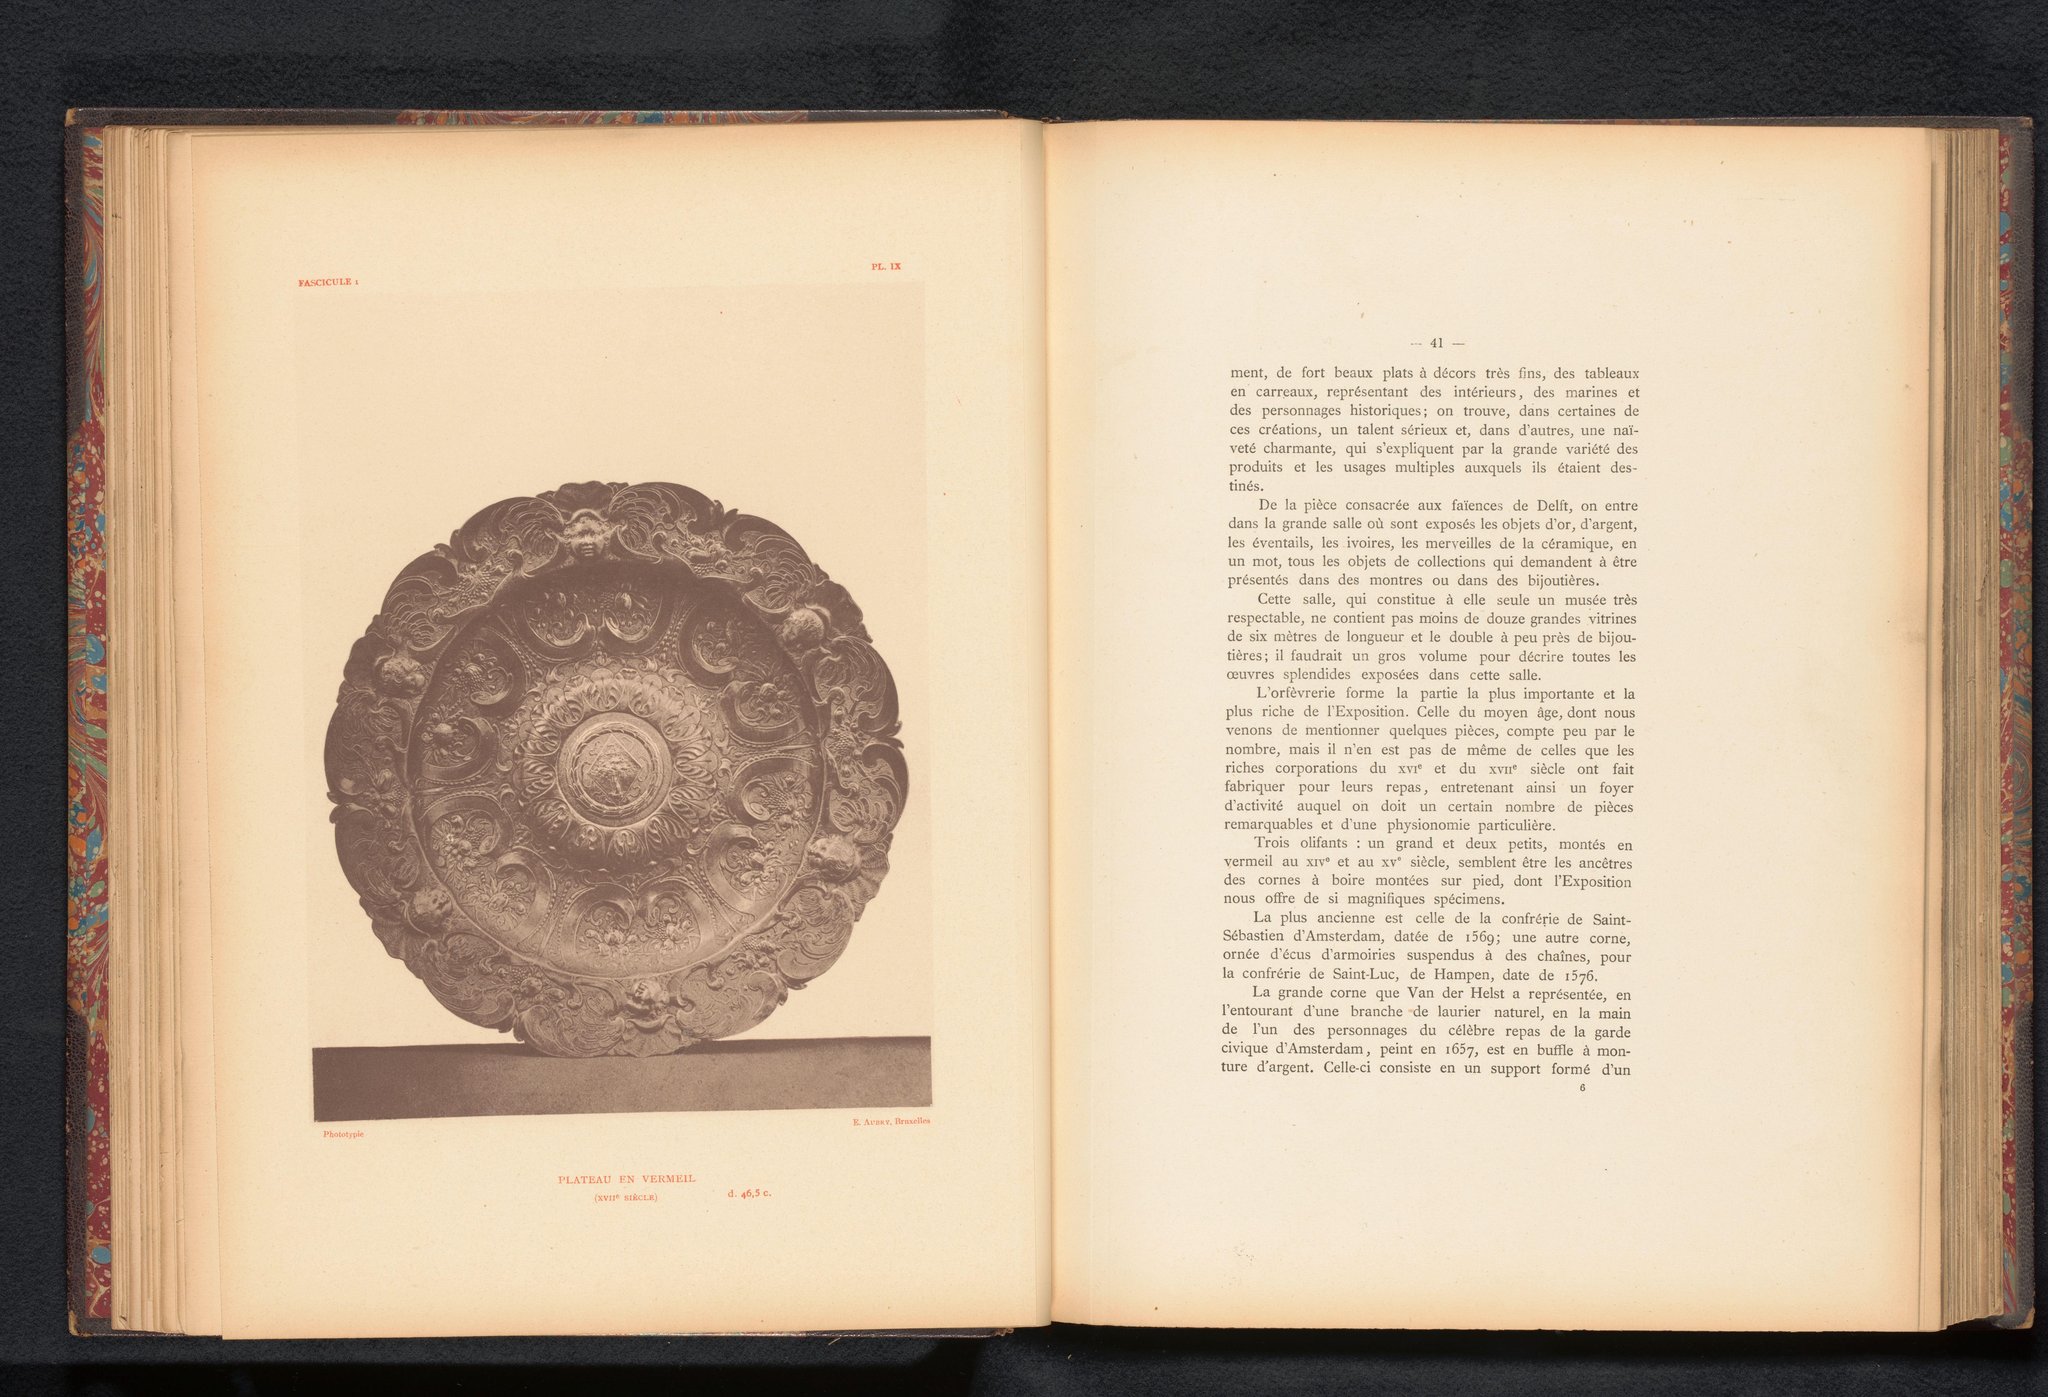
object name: page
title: Dienblad met reliëf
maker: emile aubry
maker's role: print maker, printer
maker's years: 1829-1900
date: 1878-1883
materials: paper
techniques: photograph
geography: brussels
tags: salver, sculpture (+ relief ~ sculpture)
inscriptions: inscription: ‘Fascicule I/ PL. IX’, inscription: ‘XVIIe siècle/ d. 46,5.’